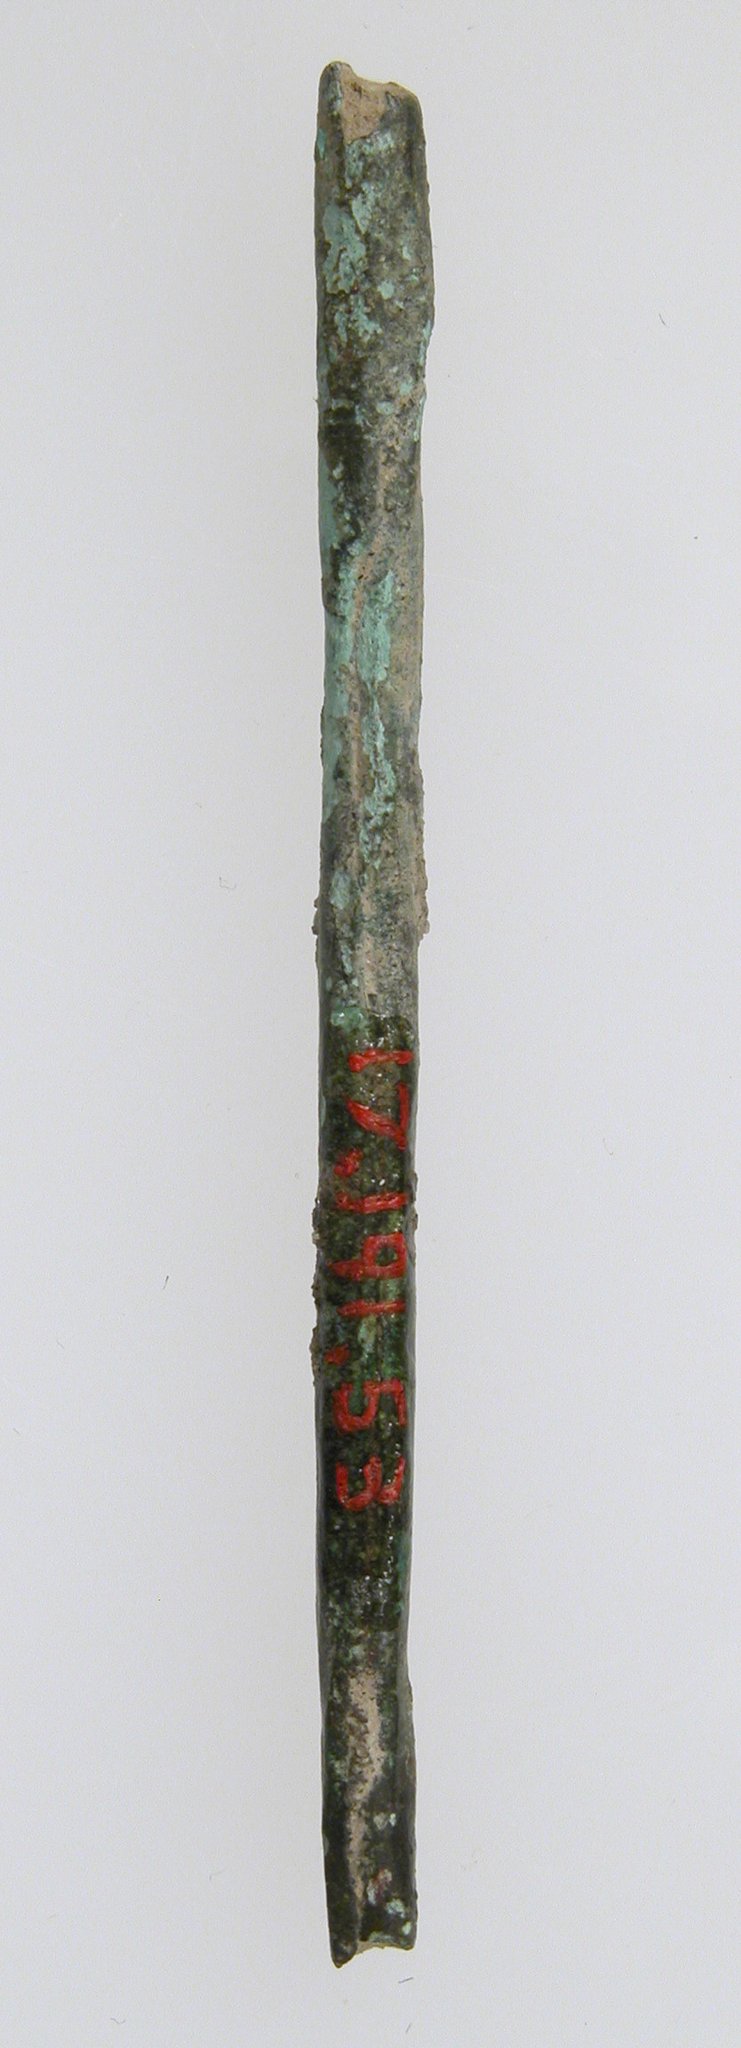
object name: hairpin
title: Hairpin Part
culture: roman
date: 1-400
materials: copper alloy